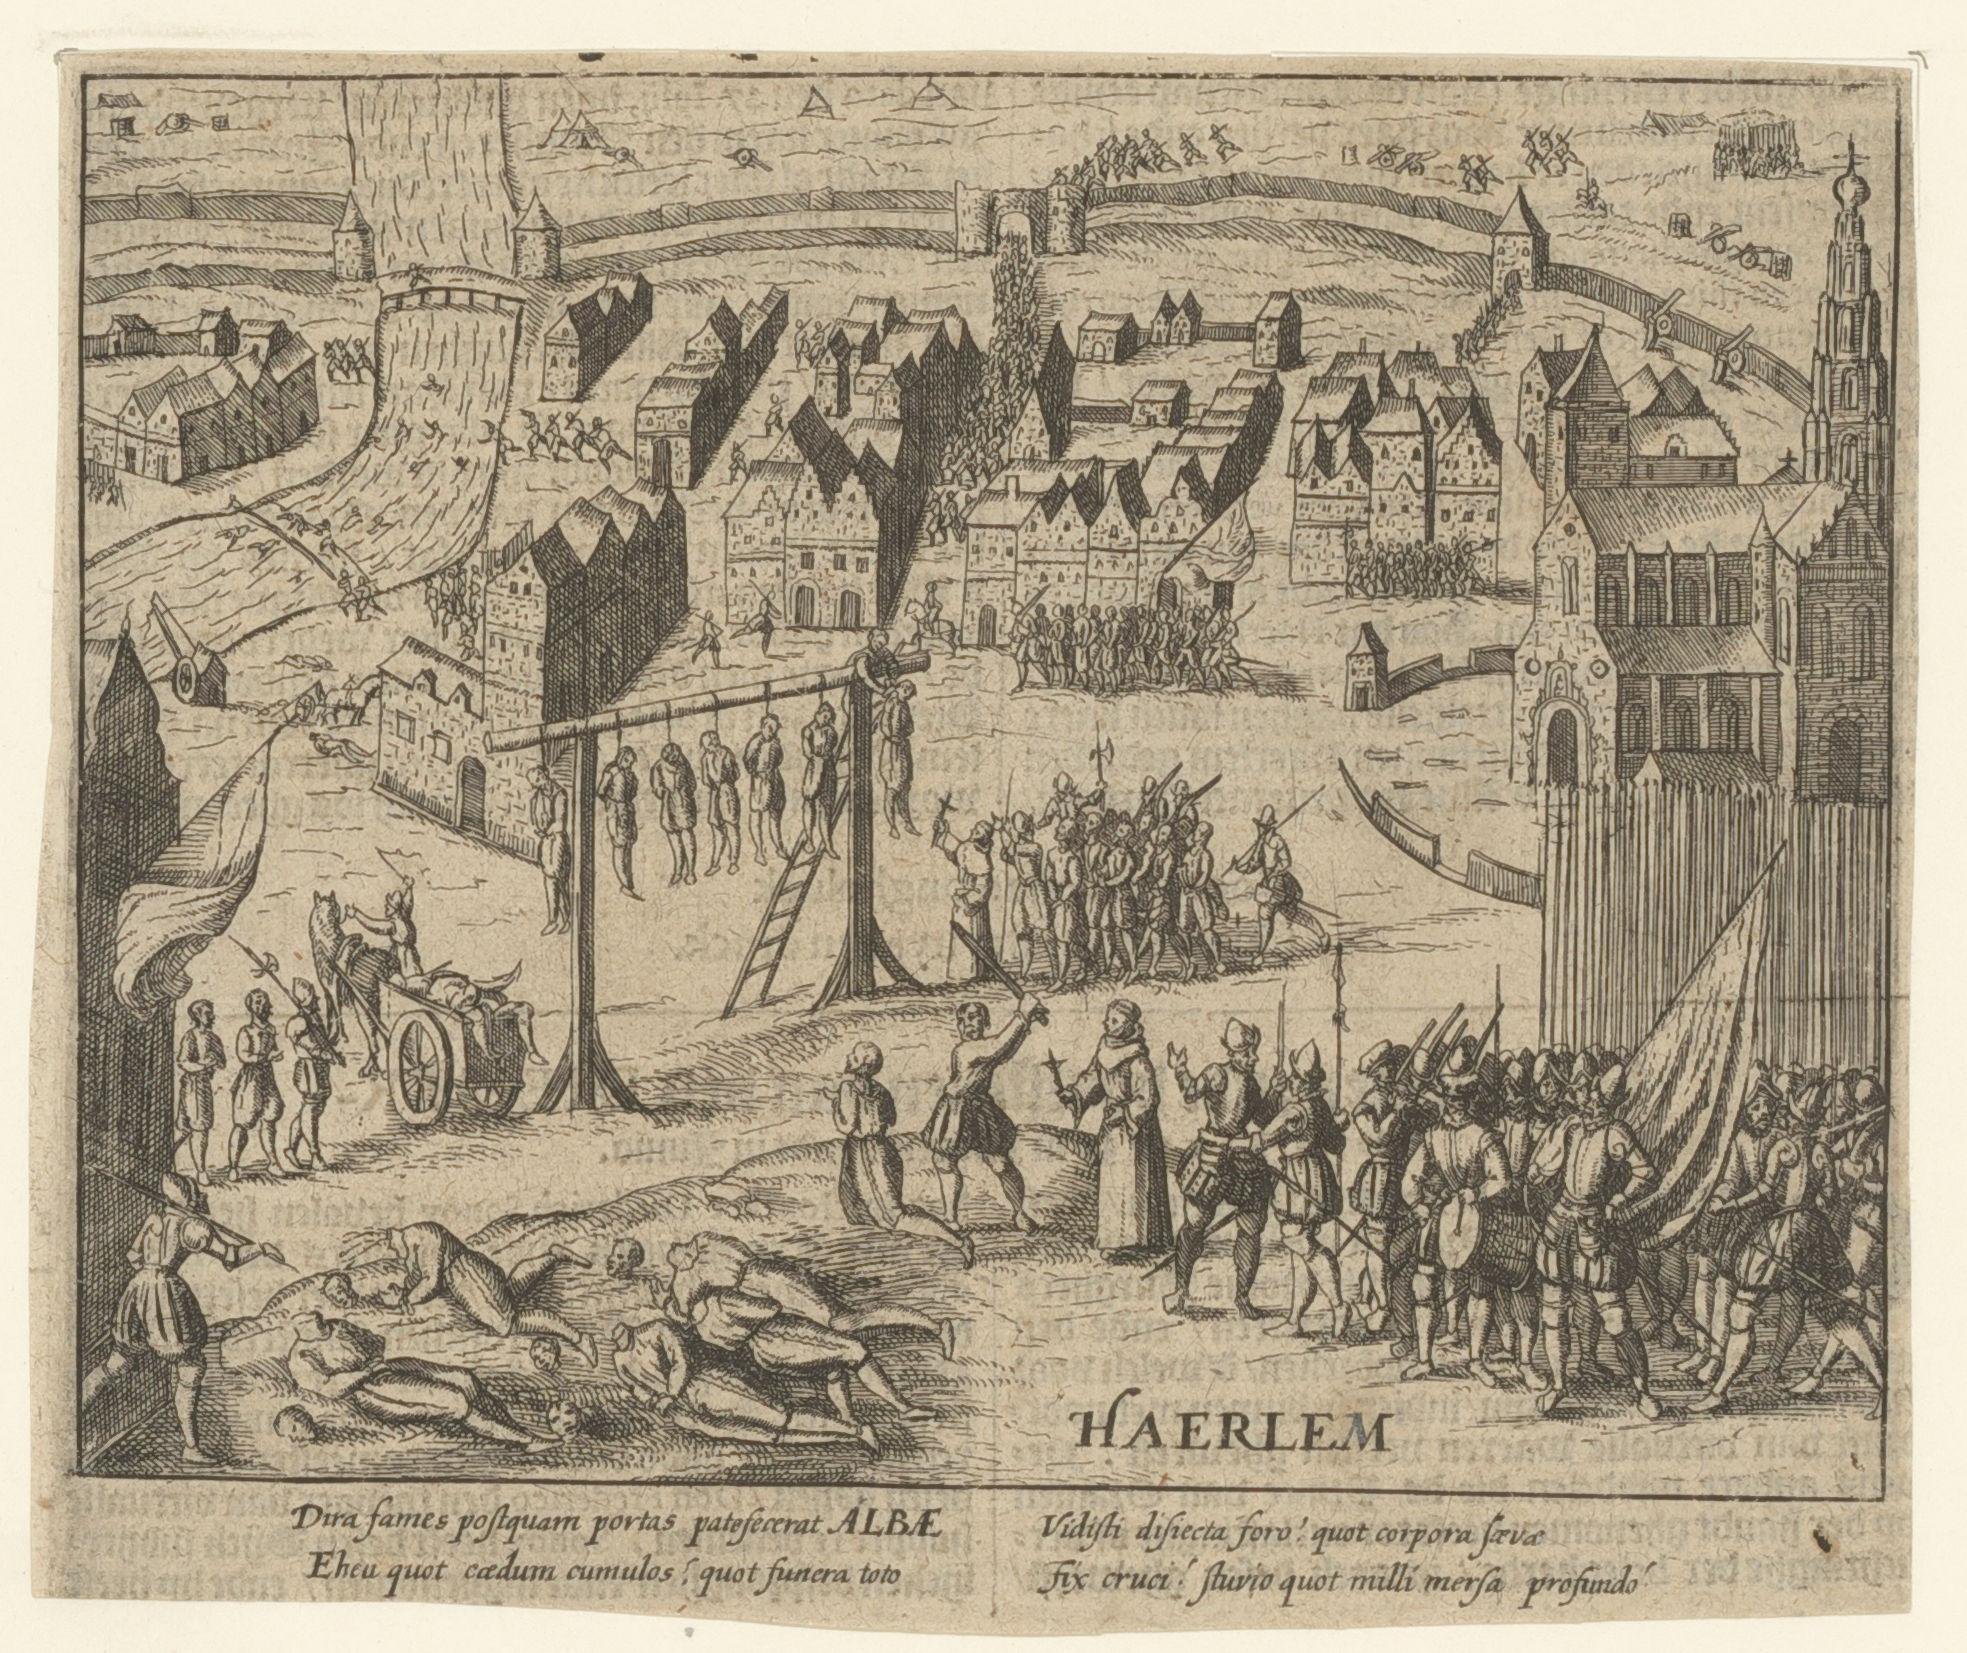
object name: history print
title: Moord te Haarlem door de Spanjaarden, 1573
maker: Anonymous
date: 1613-1615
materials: paper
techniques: etching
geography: northern netherlands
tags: violent death by hanging, massacre ~ war, violent death by beheading, haarlem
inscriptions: collector's mark: Lugt 1641, collector's mark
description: Terechtstelling en moord op de verdedigers van Haarlem door Spaanse soldaten onder Don Frederik, na de overgave van de stad op 13 juli 1573. Op de voorgrond onthoofdingen en ophangingen, links worden lichamen in een kar afgevoerd. Op de achtergrond worden anderen in het water verdronken. Met onderschrift van 4 regels in het Latijn. Genummerd: 37 (afgesneden). Bedrukt op achterzijde met tekst in het Nederlands. Onderwerpsrubrieken binnen de Atlas Zeden en Gewoonten: Krijgswezen; prenten van Baudart. 80j. oorlog.